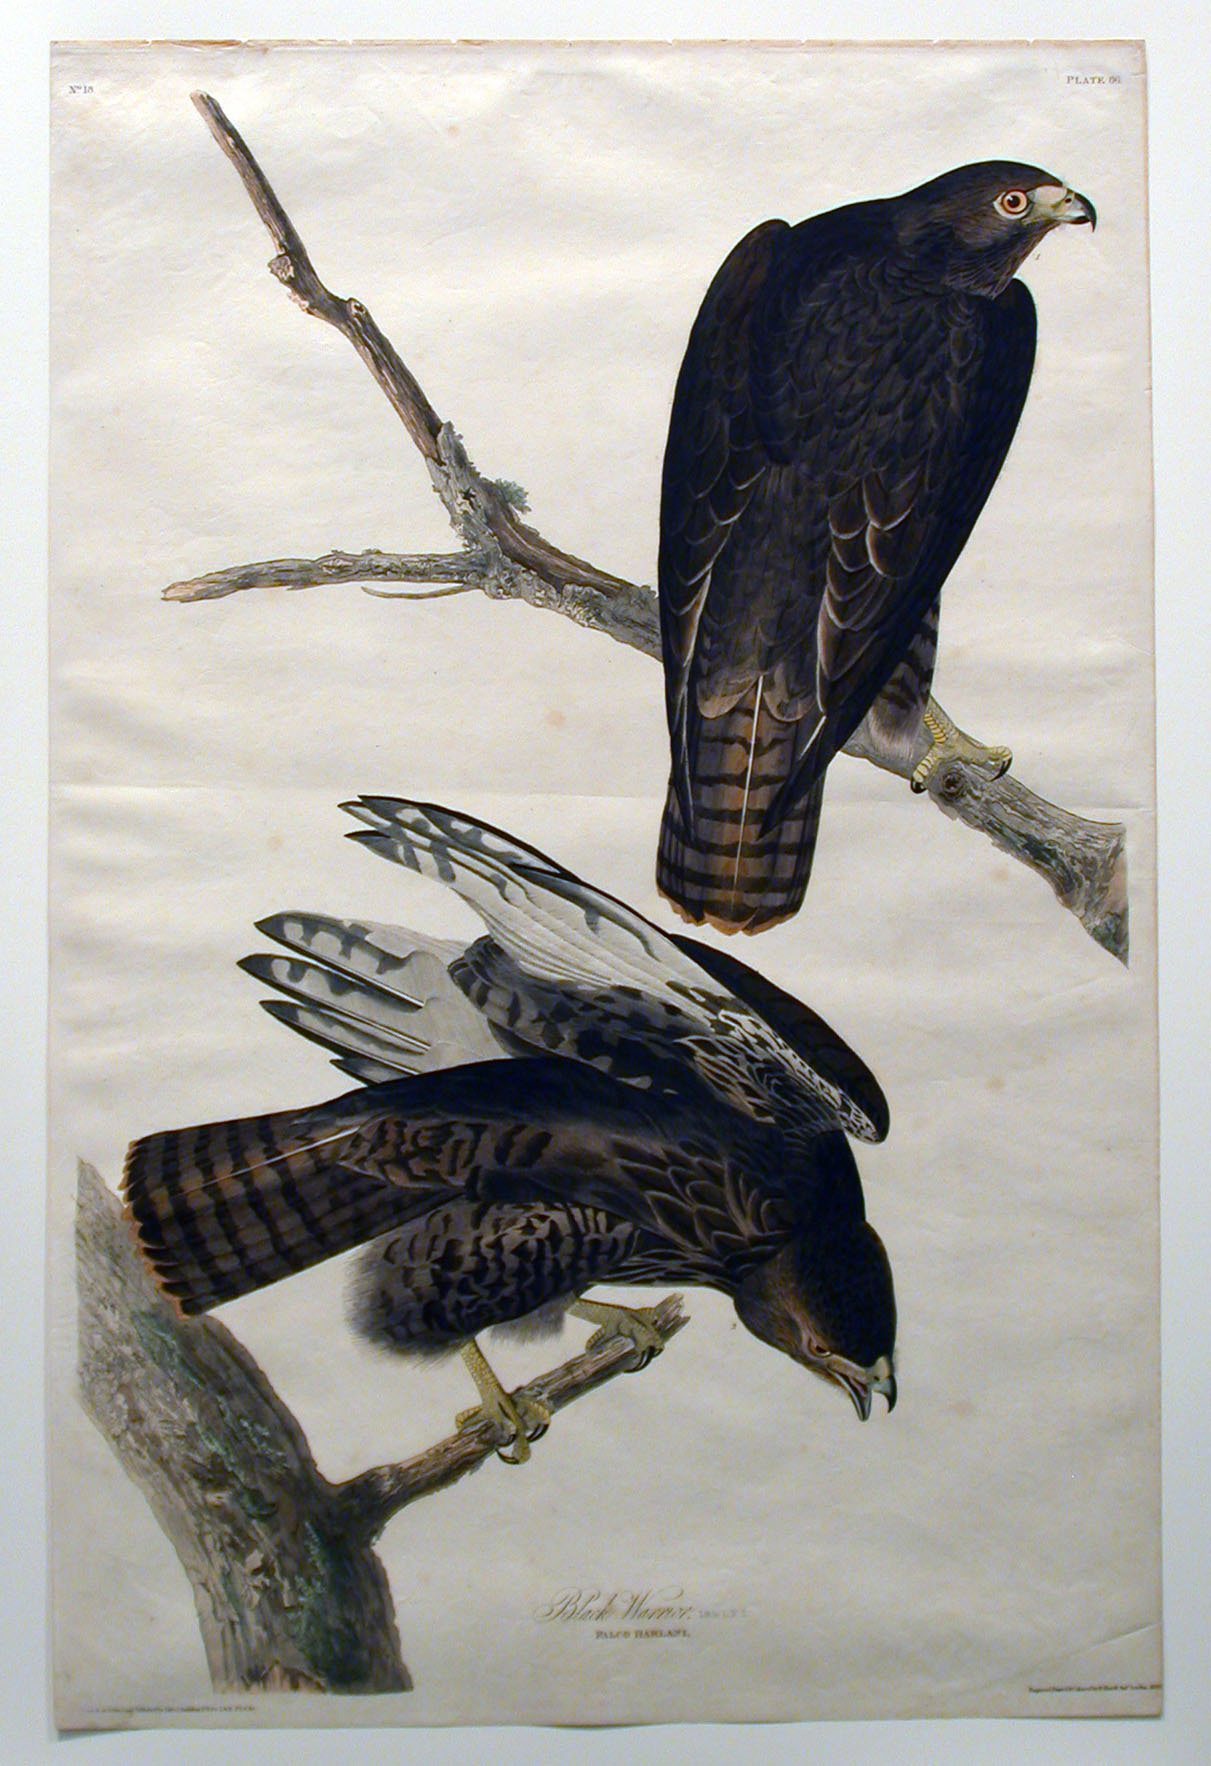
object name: print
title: Black Warrior (No. 18)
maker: john james audubon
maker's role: artist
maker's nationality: american, born haiti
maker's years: 1785-1851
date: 1830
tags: birds